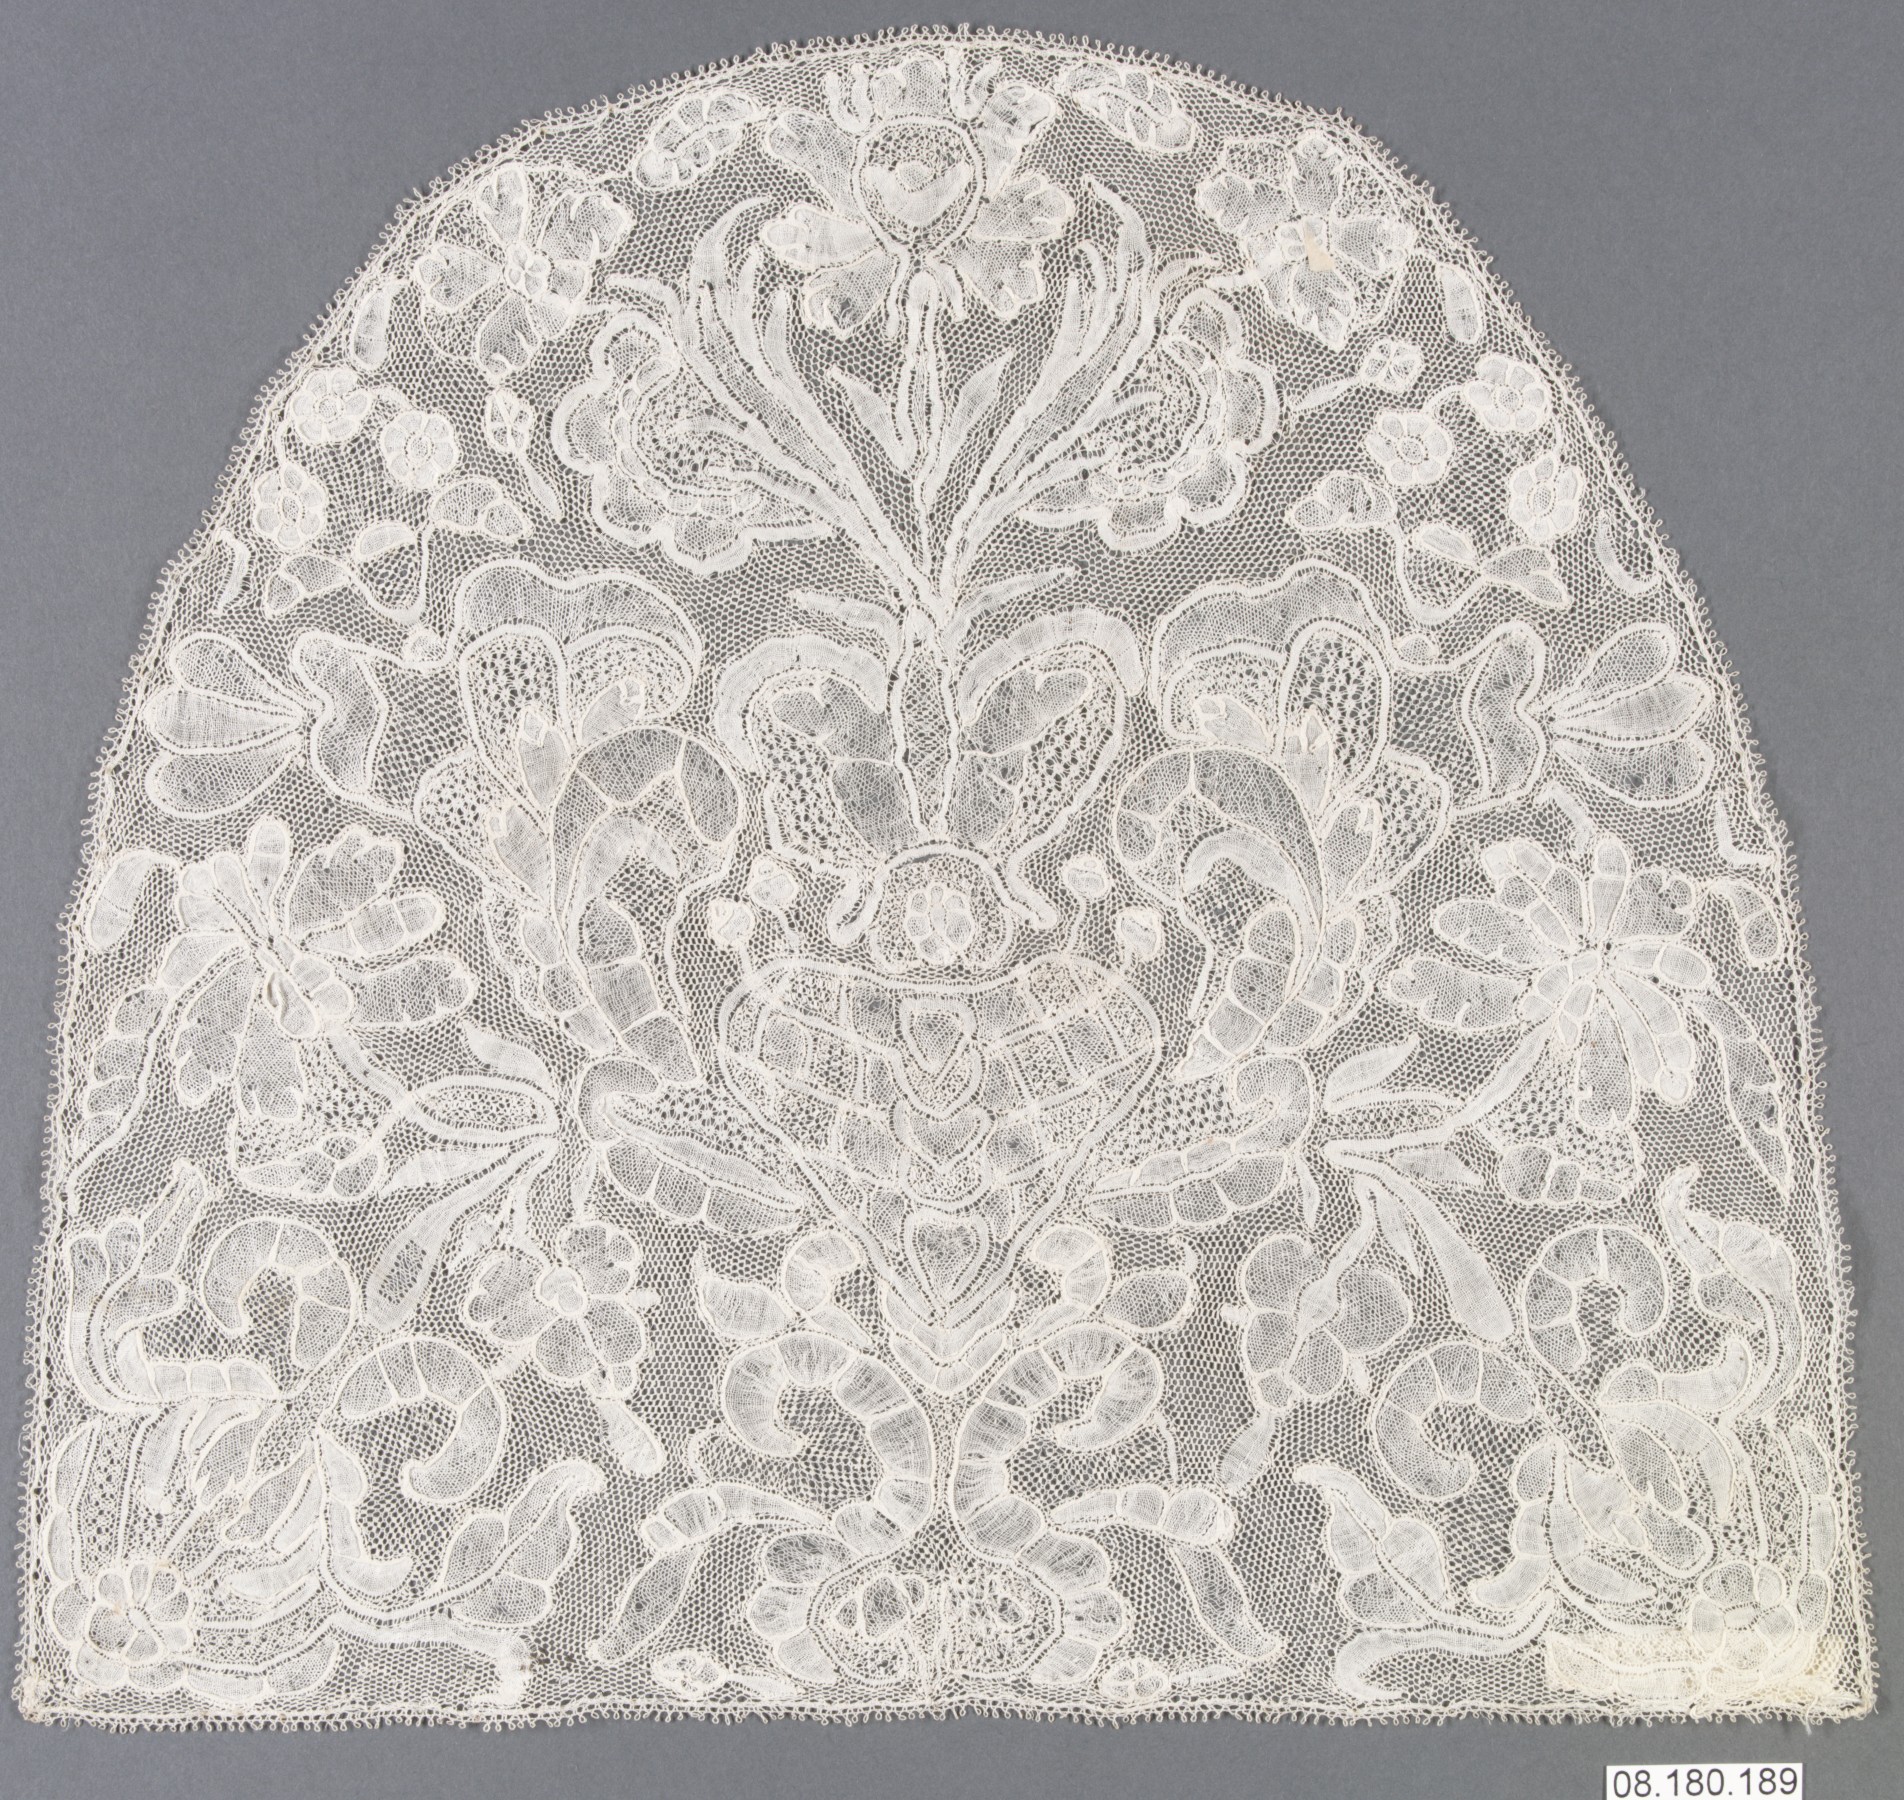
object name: cap crown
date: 1767-1800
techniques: lace